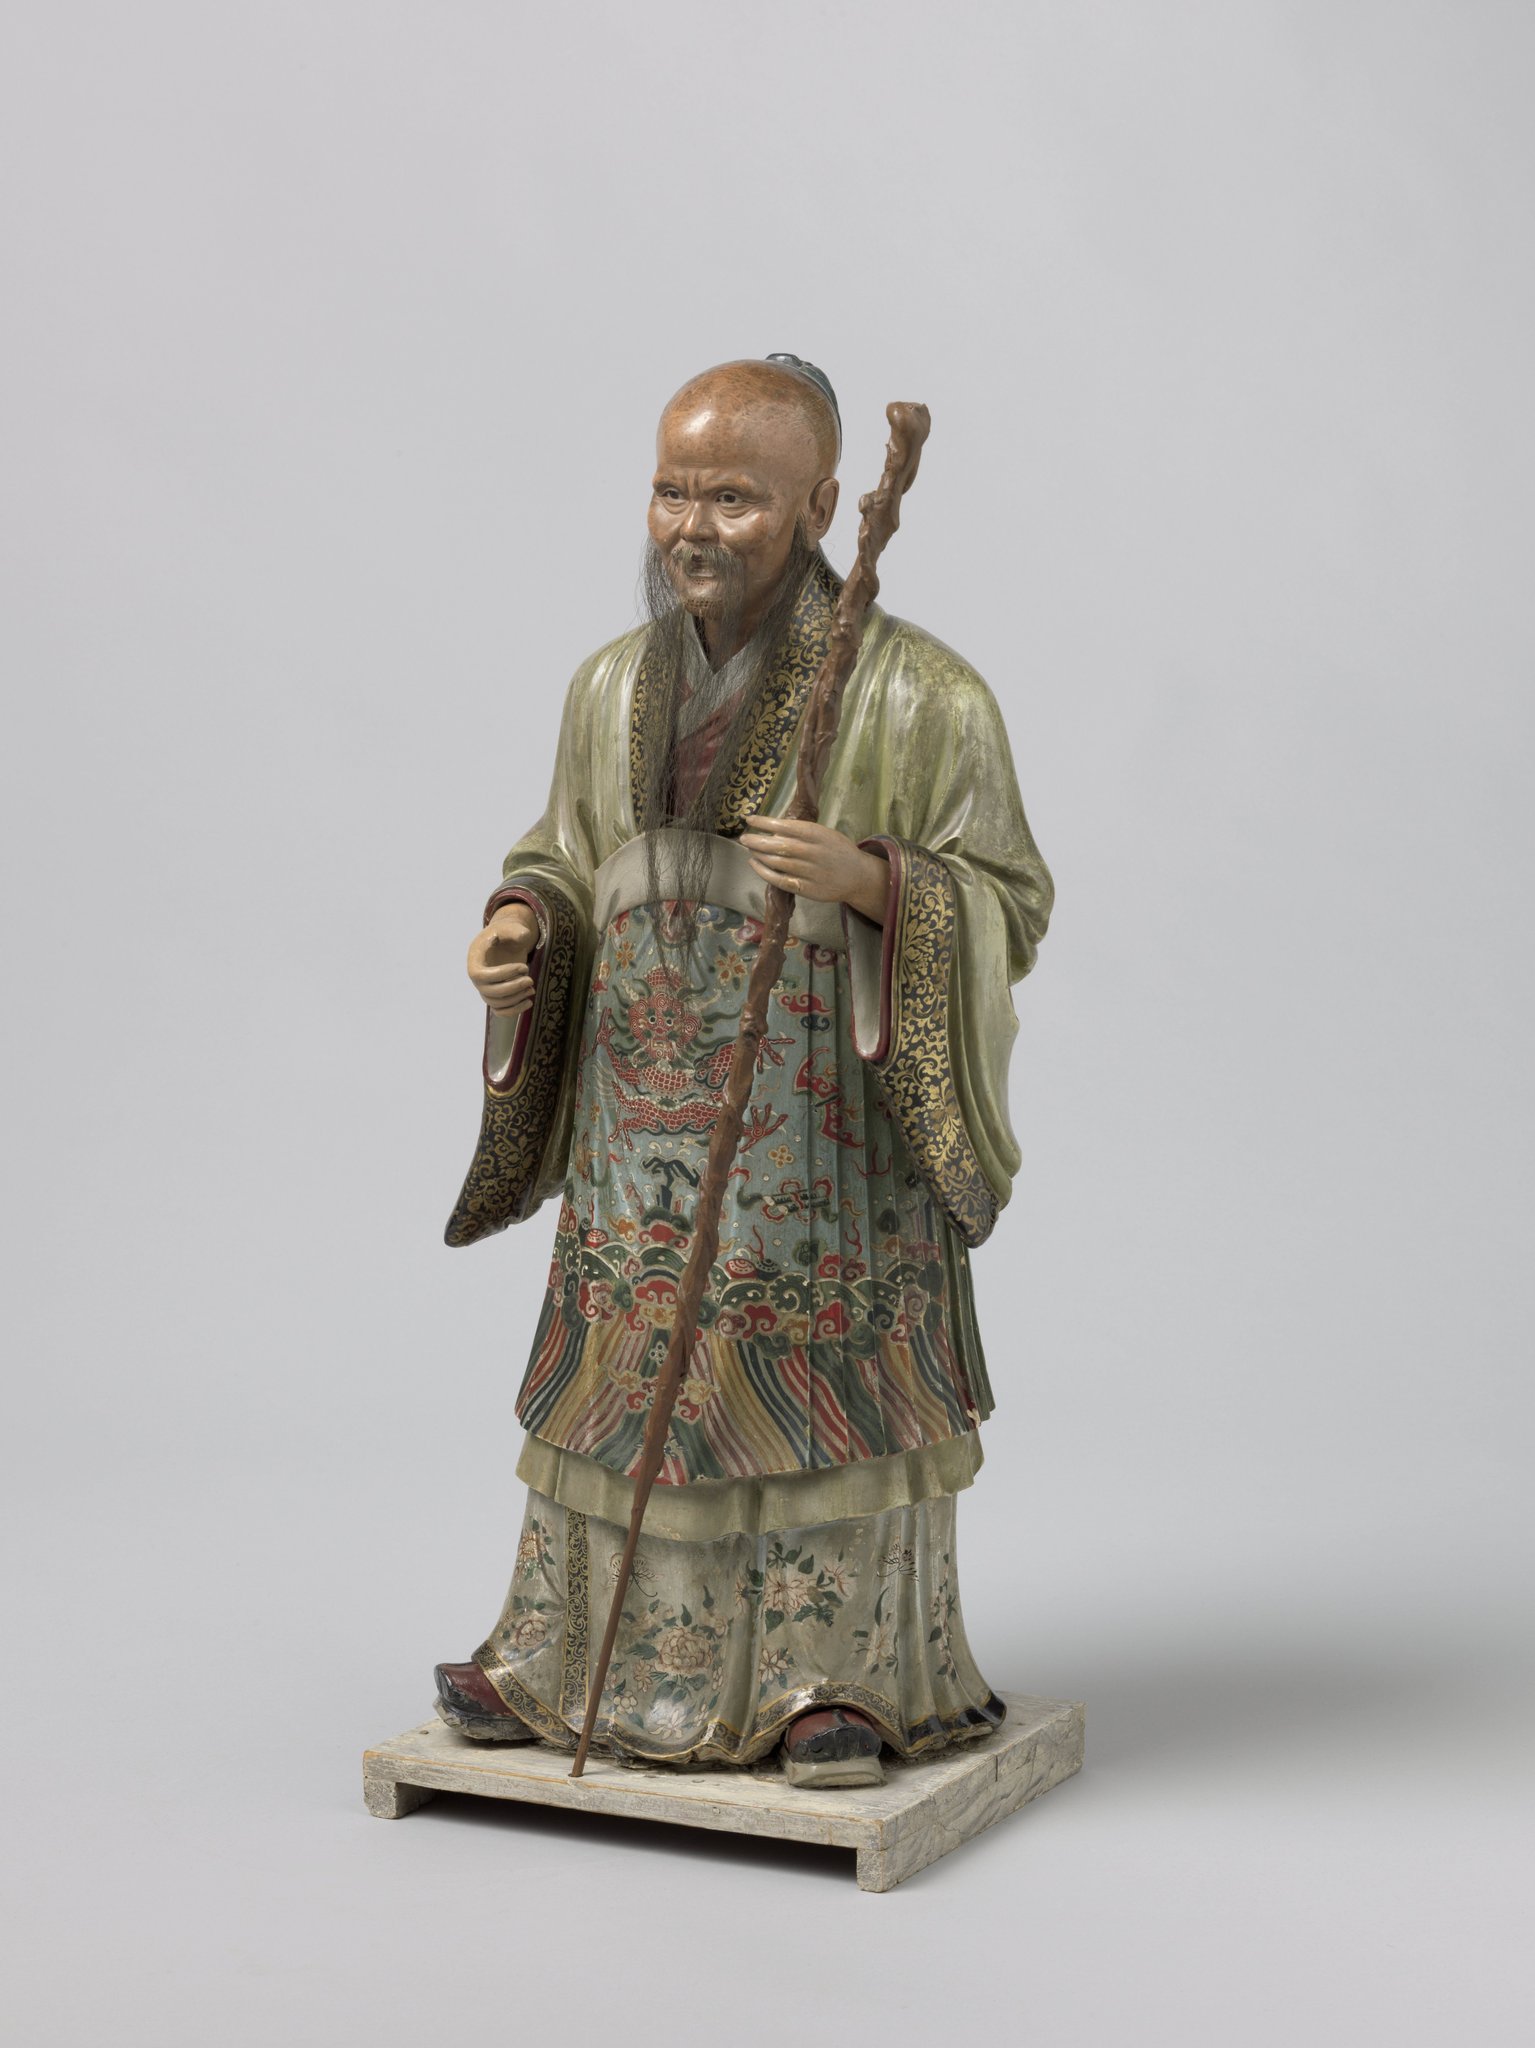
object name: doll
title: Hoofd van een staande Chinese knikpop (man)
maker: Anonymous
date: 1804-1808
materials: hair, iron, lead, earth, porcelain, wood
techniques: woodworking, molding, polychromy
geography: china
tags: china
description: Geschenk van de Keizer van China aan A.H. van Limburg Brouwer, Lid van de Raad der Aziatische Bezittingen en Etablissementen tijdens de Bataafse Republiek.